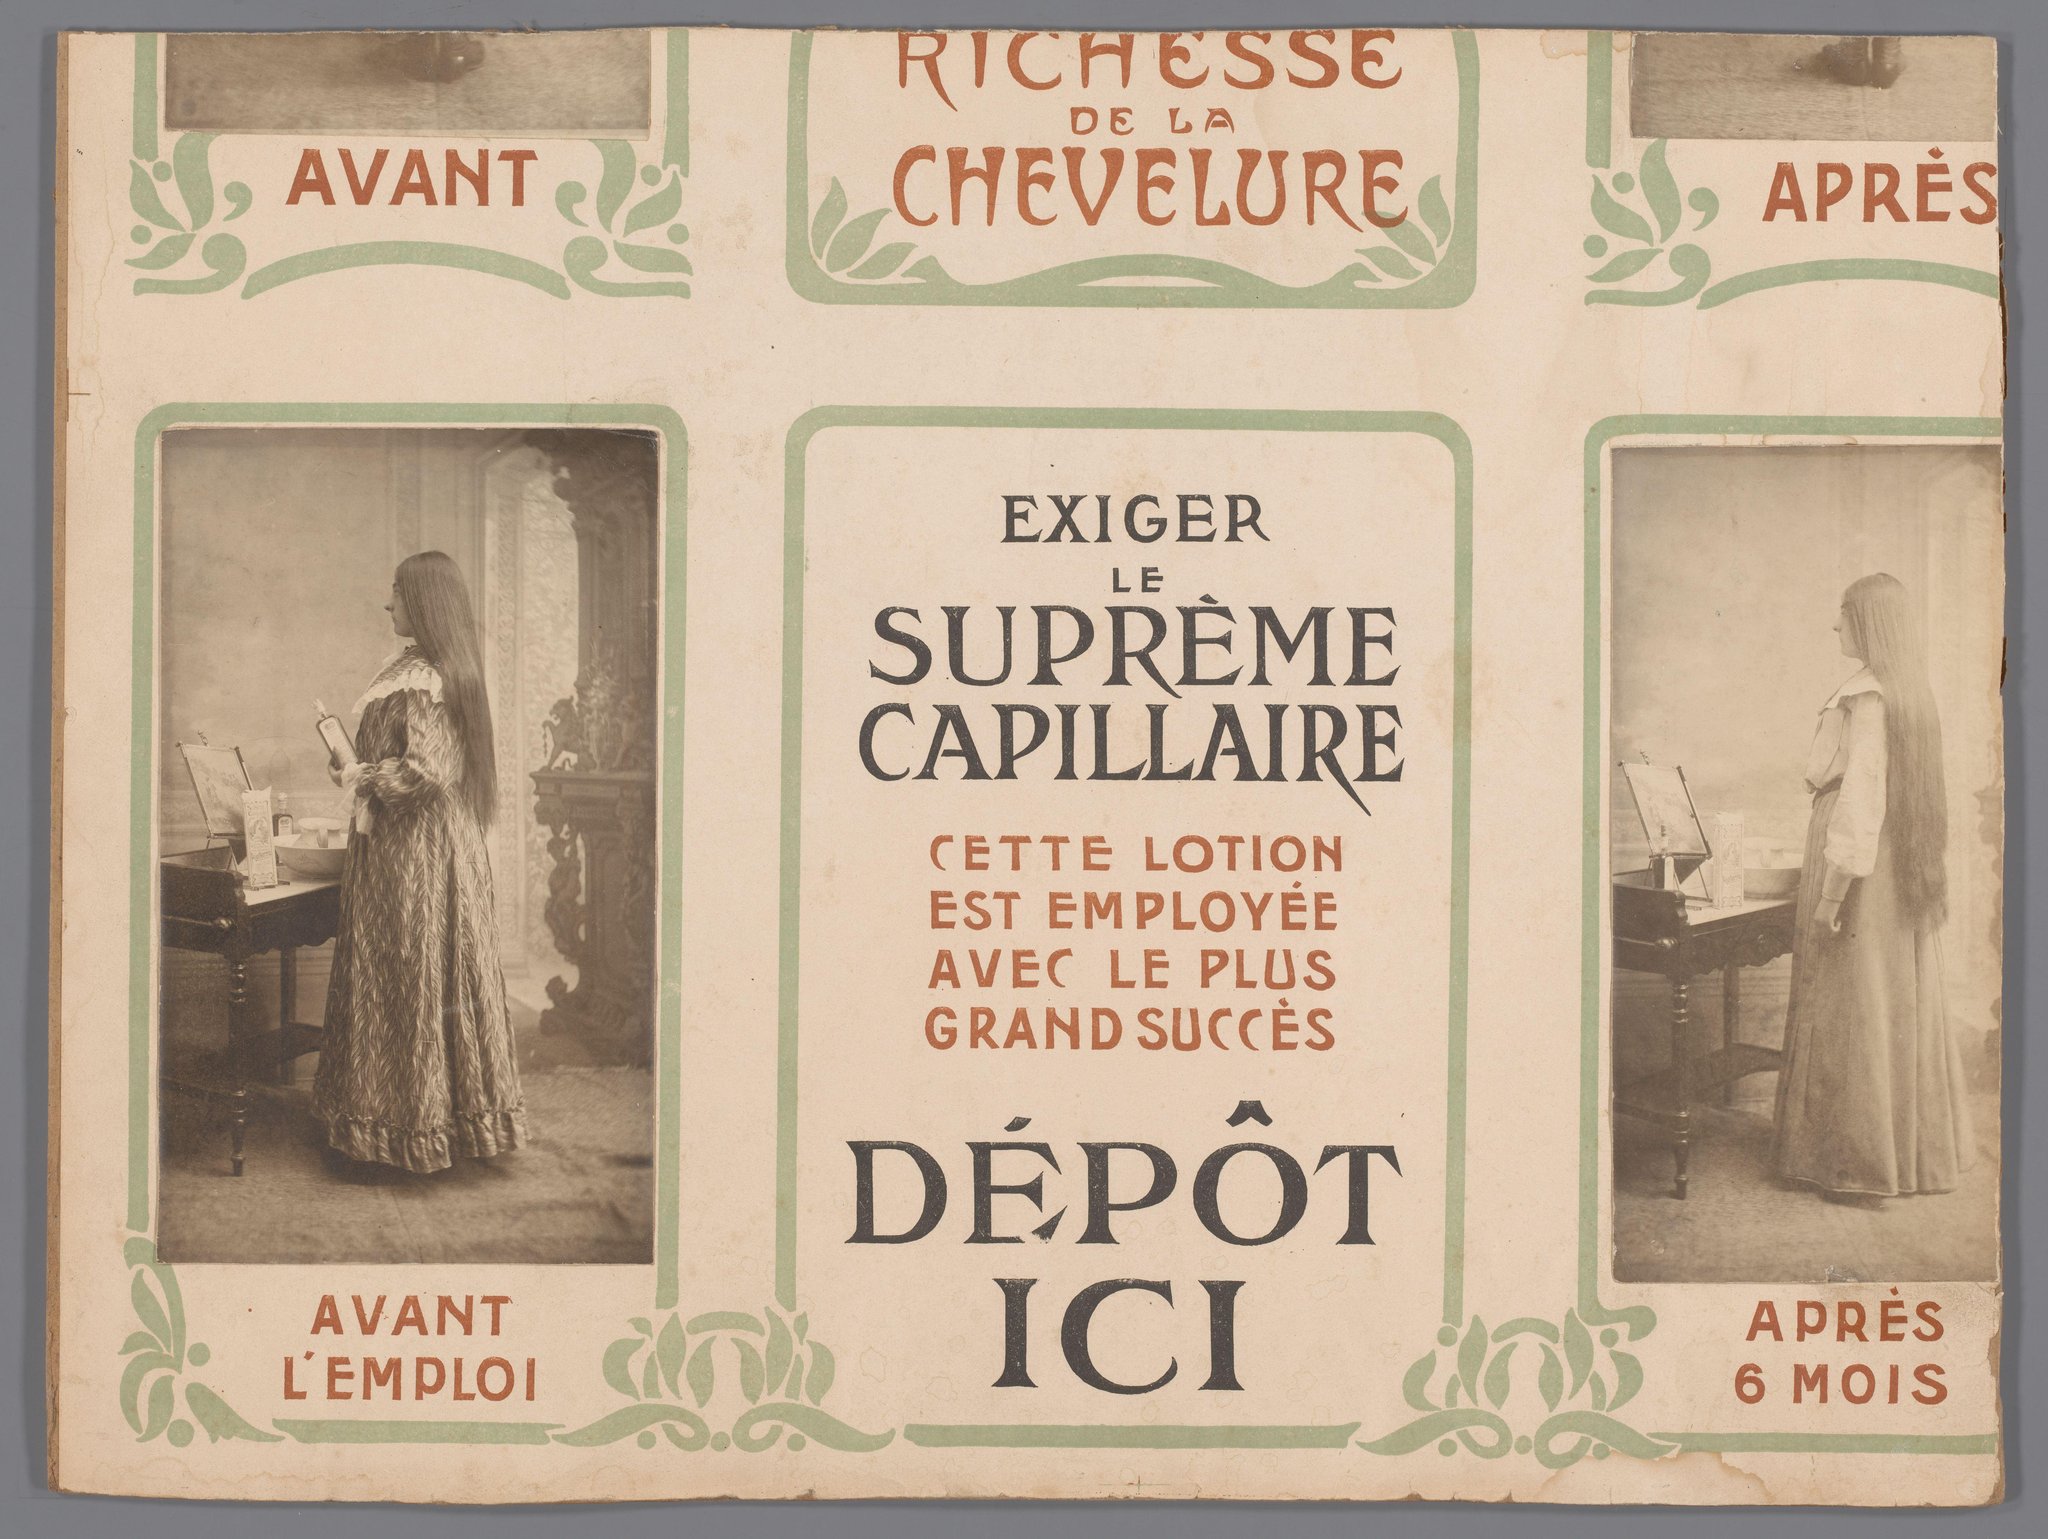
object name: photograph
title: Twee opnames van een vrouw bij een toilettafel om de haargroei in zes maanden te demonstreren, reclame voor 'le supreme Capillaire'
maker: Anonymous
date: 1890-1910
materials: cardboard, paper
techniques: albumen print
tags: care of the hair